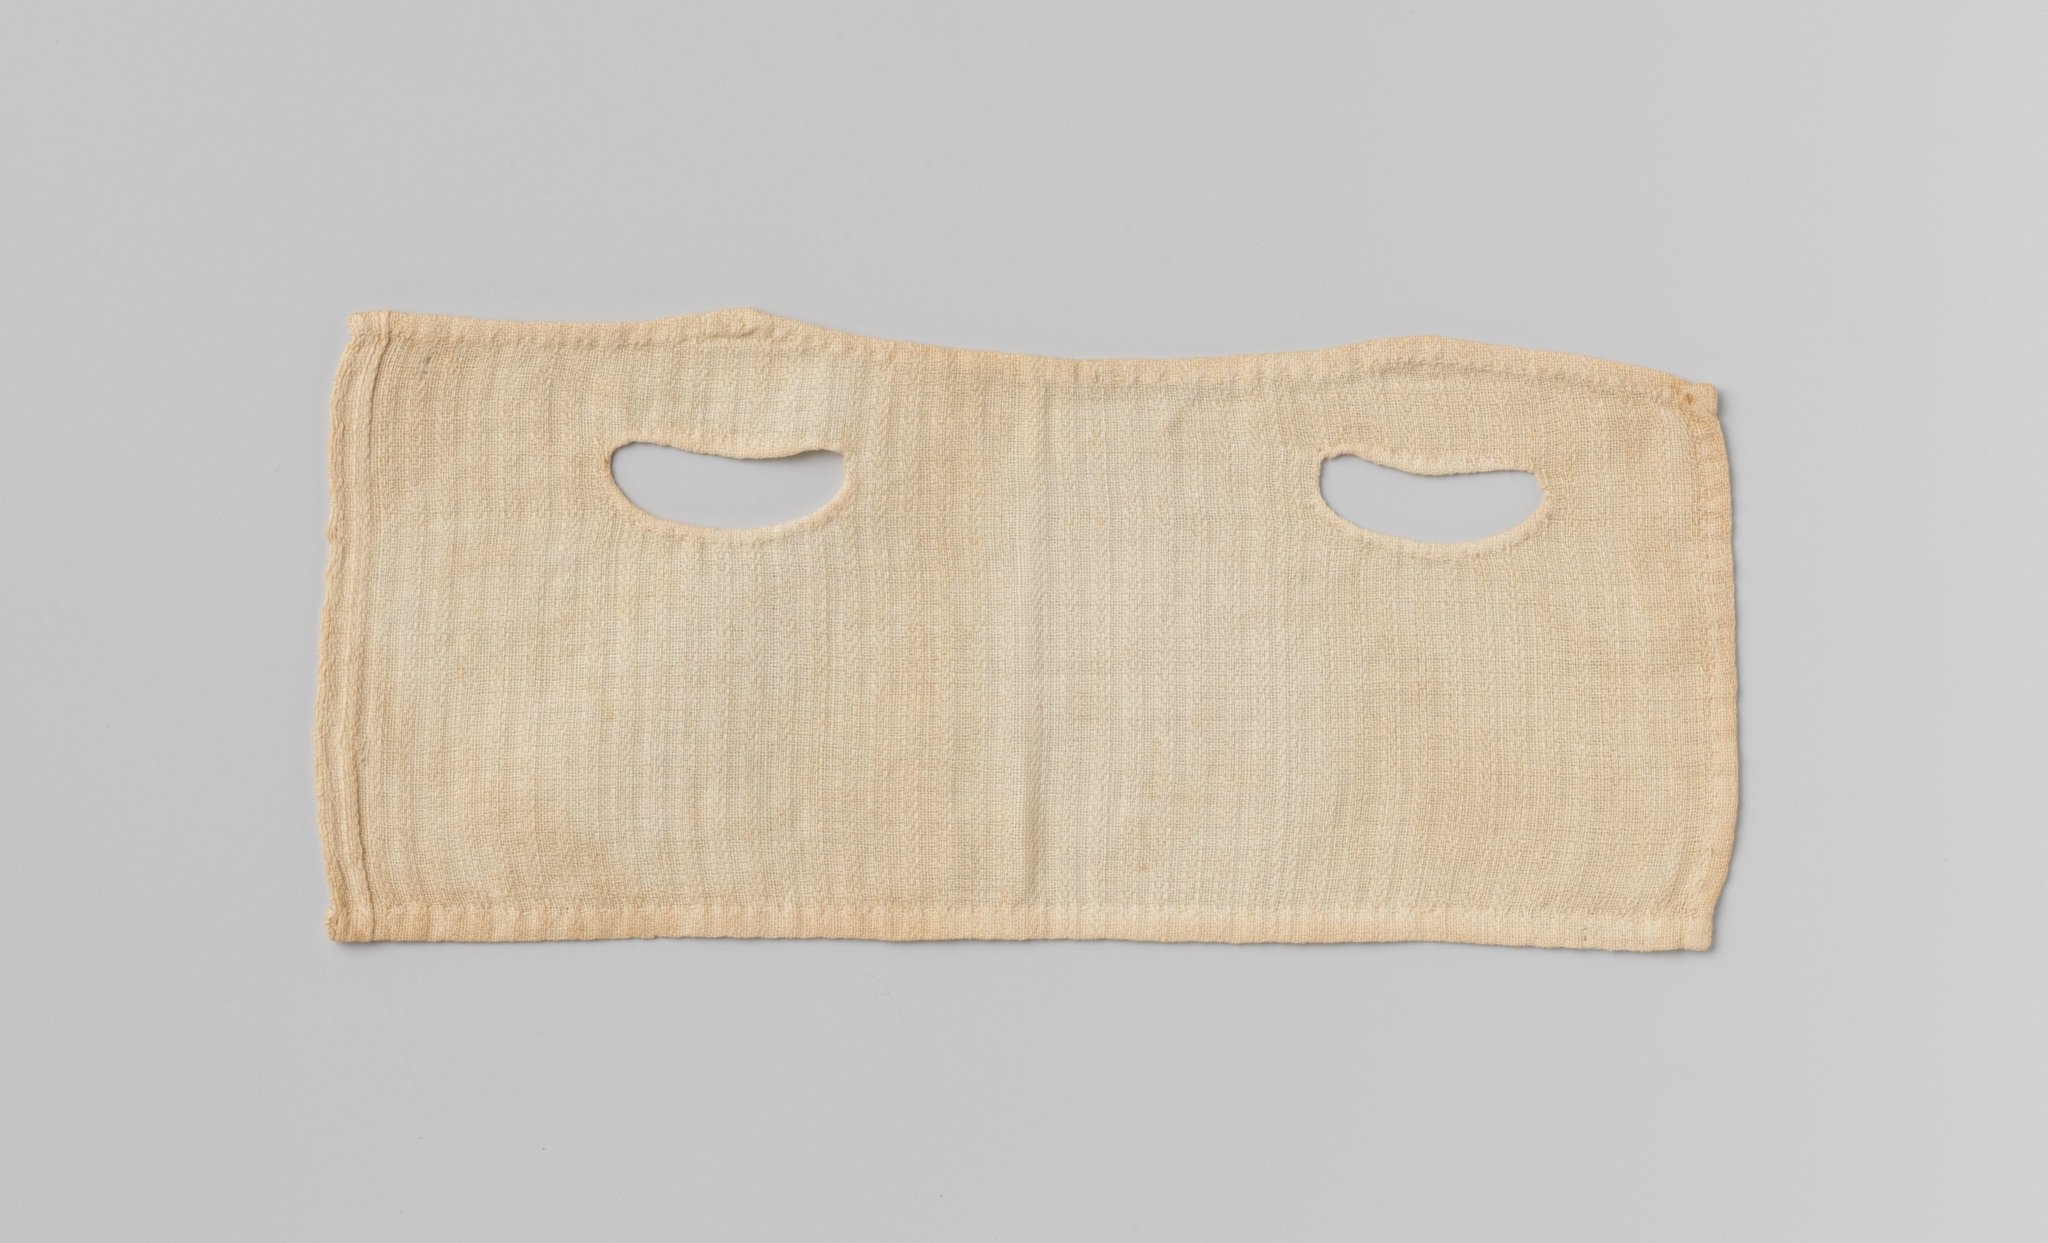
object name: doll's clothing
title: Onderlijf met gekeperd streepmotief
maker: Anonymous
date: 1750-1800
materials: cotton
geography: netherlands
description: Een lijf van katoen met gekeperd streepmotief; Rechthoekige lap met twee horizontale halve maanvormige gaten.